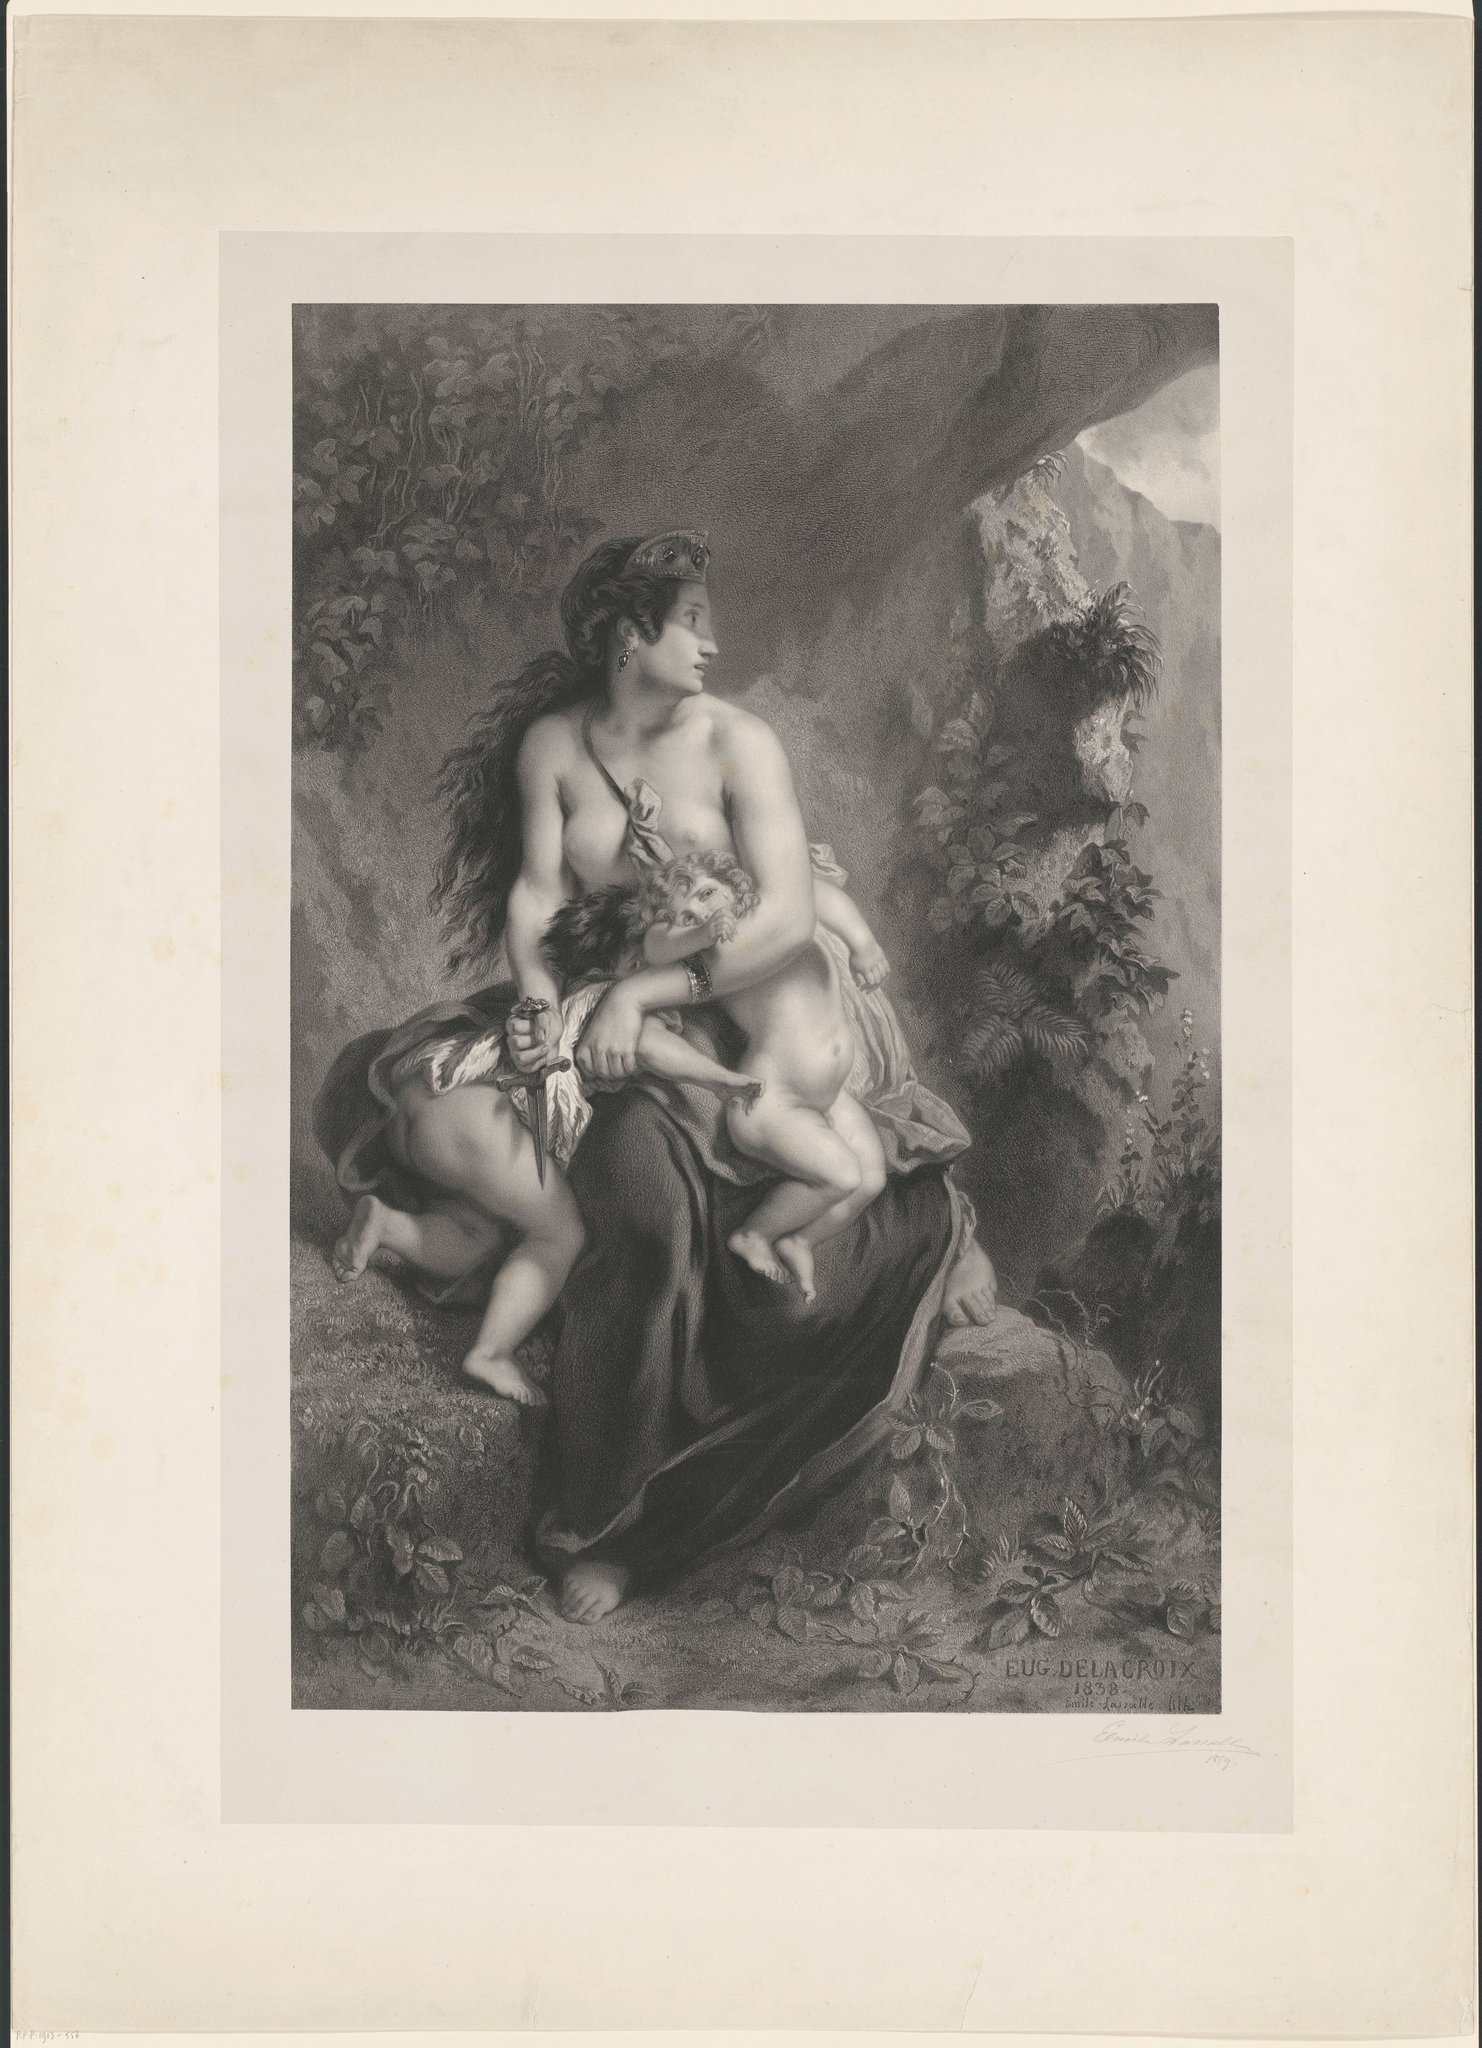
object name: print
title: Woedende Medea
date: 1859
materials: paper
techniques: lithograph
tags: medea kills her two children; she flees from corinth in a chariot drawn by winged dragons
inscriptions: collector's mark: Lugt 2233